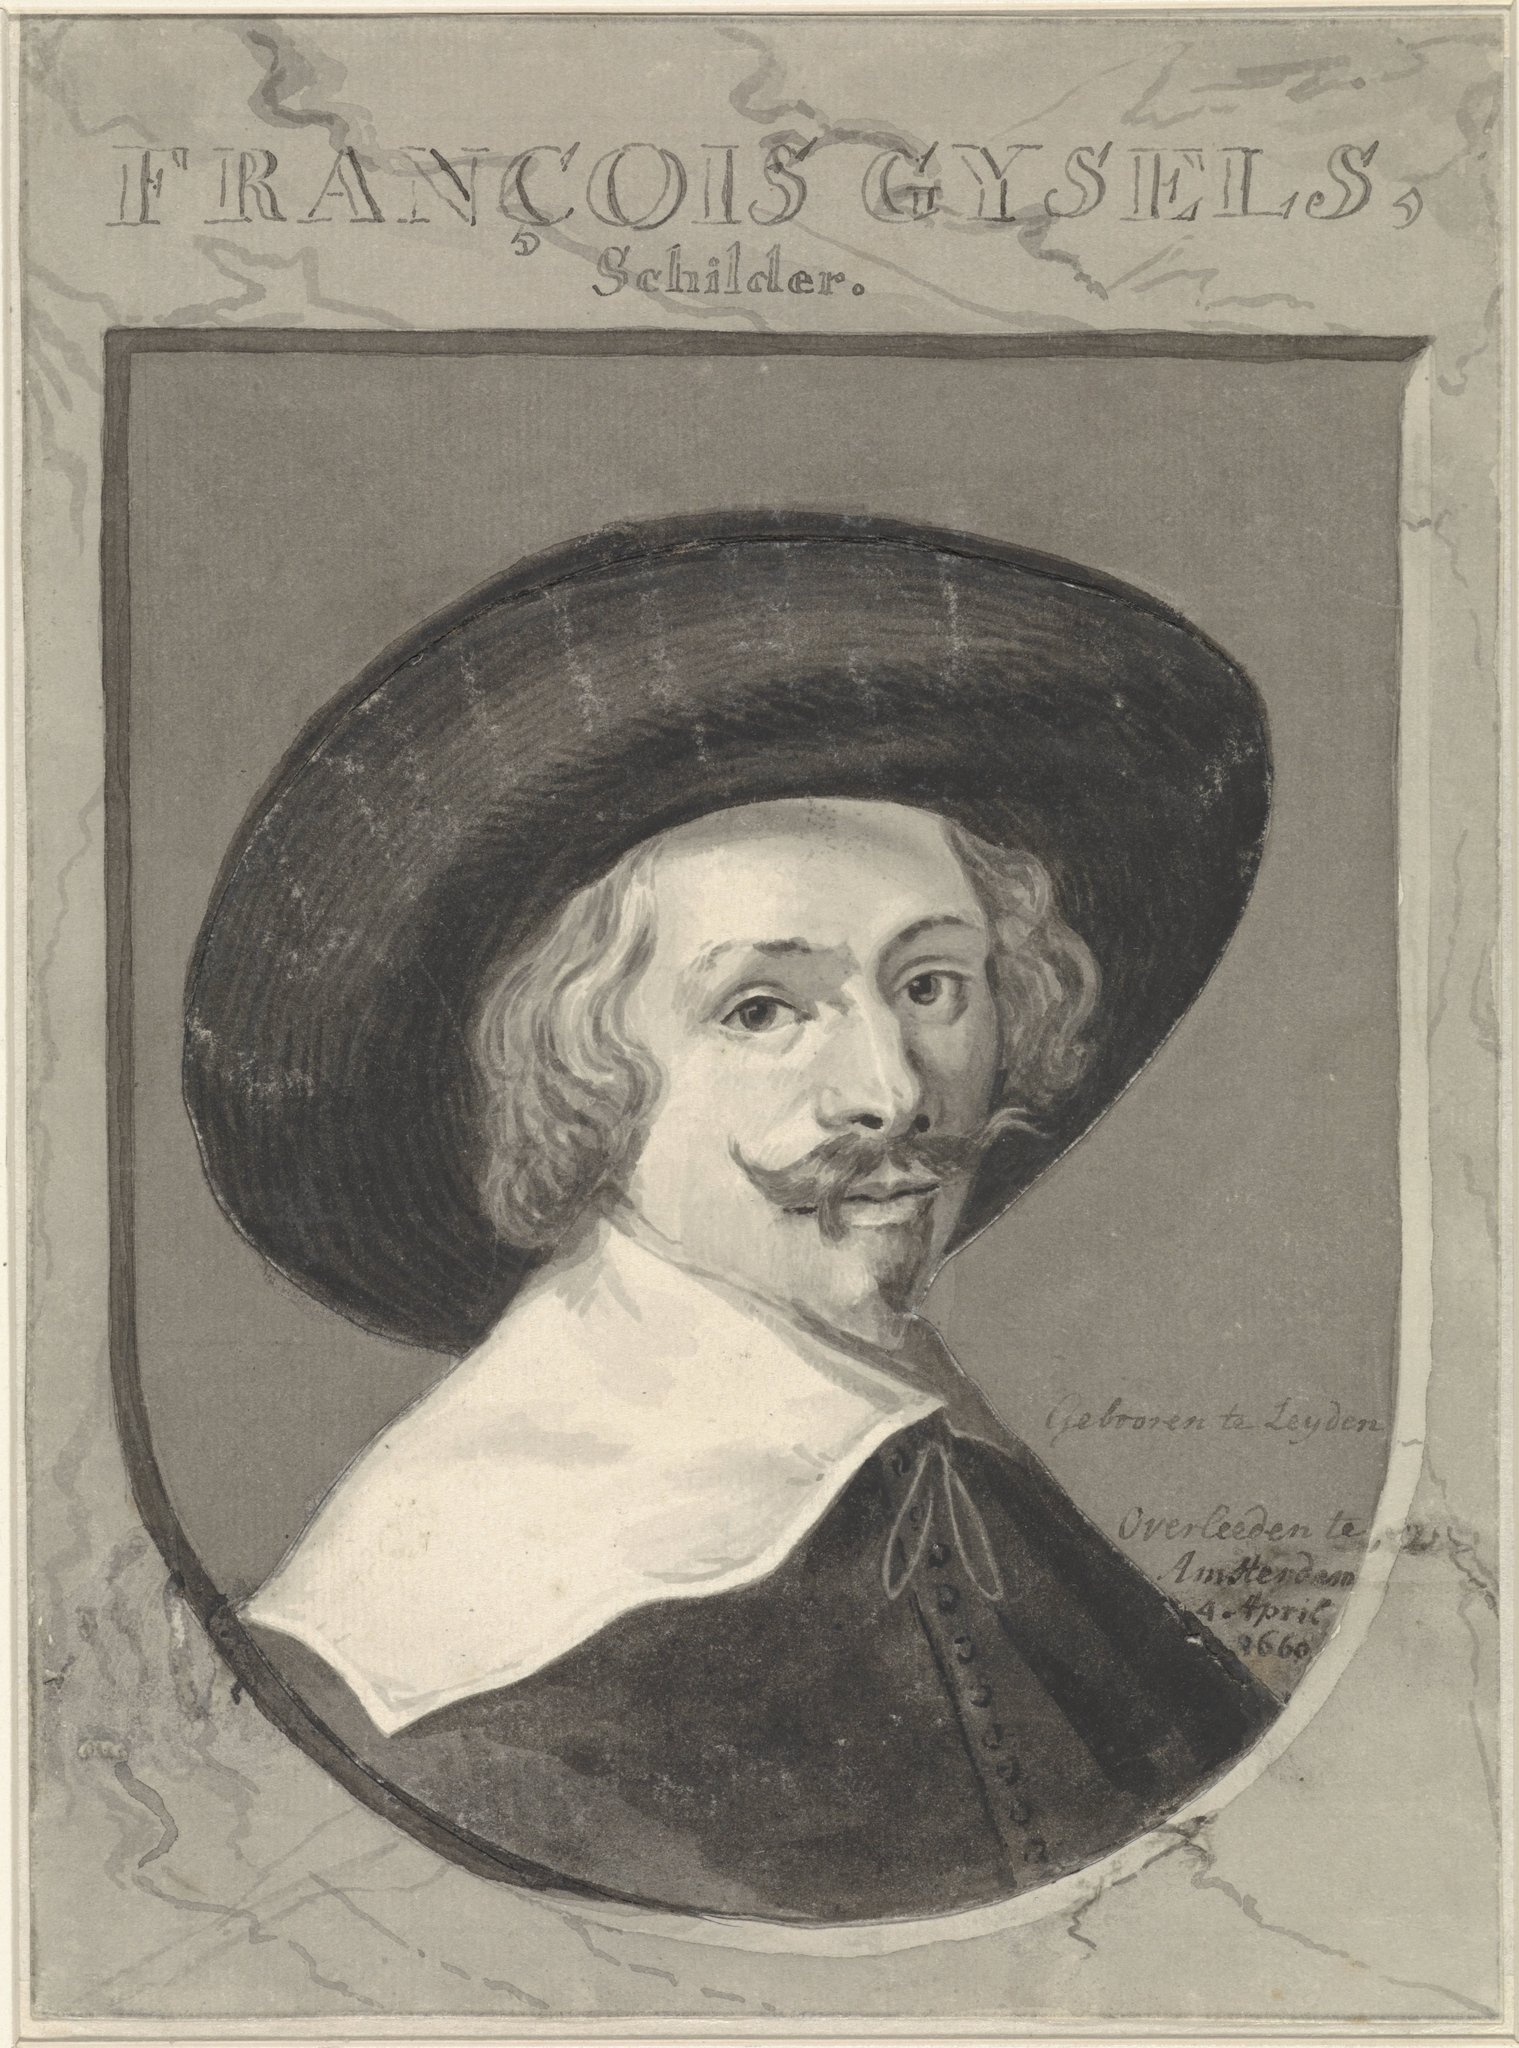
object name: drawing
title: Portret van Frans Gijsels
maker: gerard van nijmegen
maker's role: draughtsman, painter, print maker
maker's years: 1735-1808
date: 1776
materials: ink, paper, watercolor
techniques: brush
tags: historical persons, portrait, self-portrait of painter, portrait, self-portrait of artist, portrait, self-portrait of draughtsman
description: Portret van Frans Gijsels (schouderstuk uitgesneden en op ander vel geplakt).